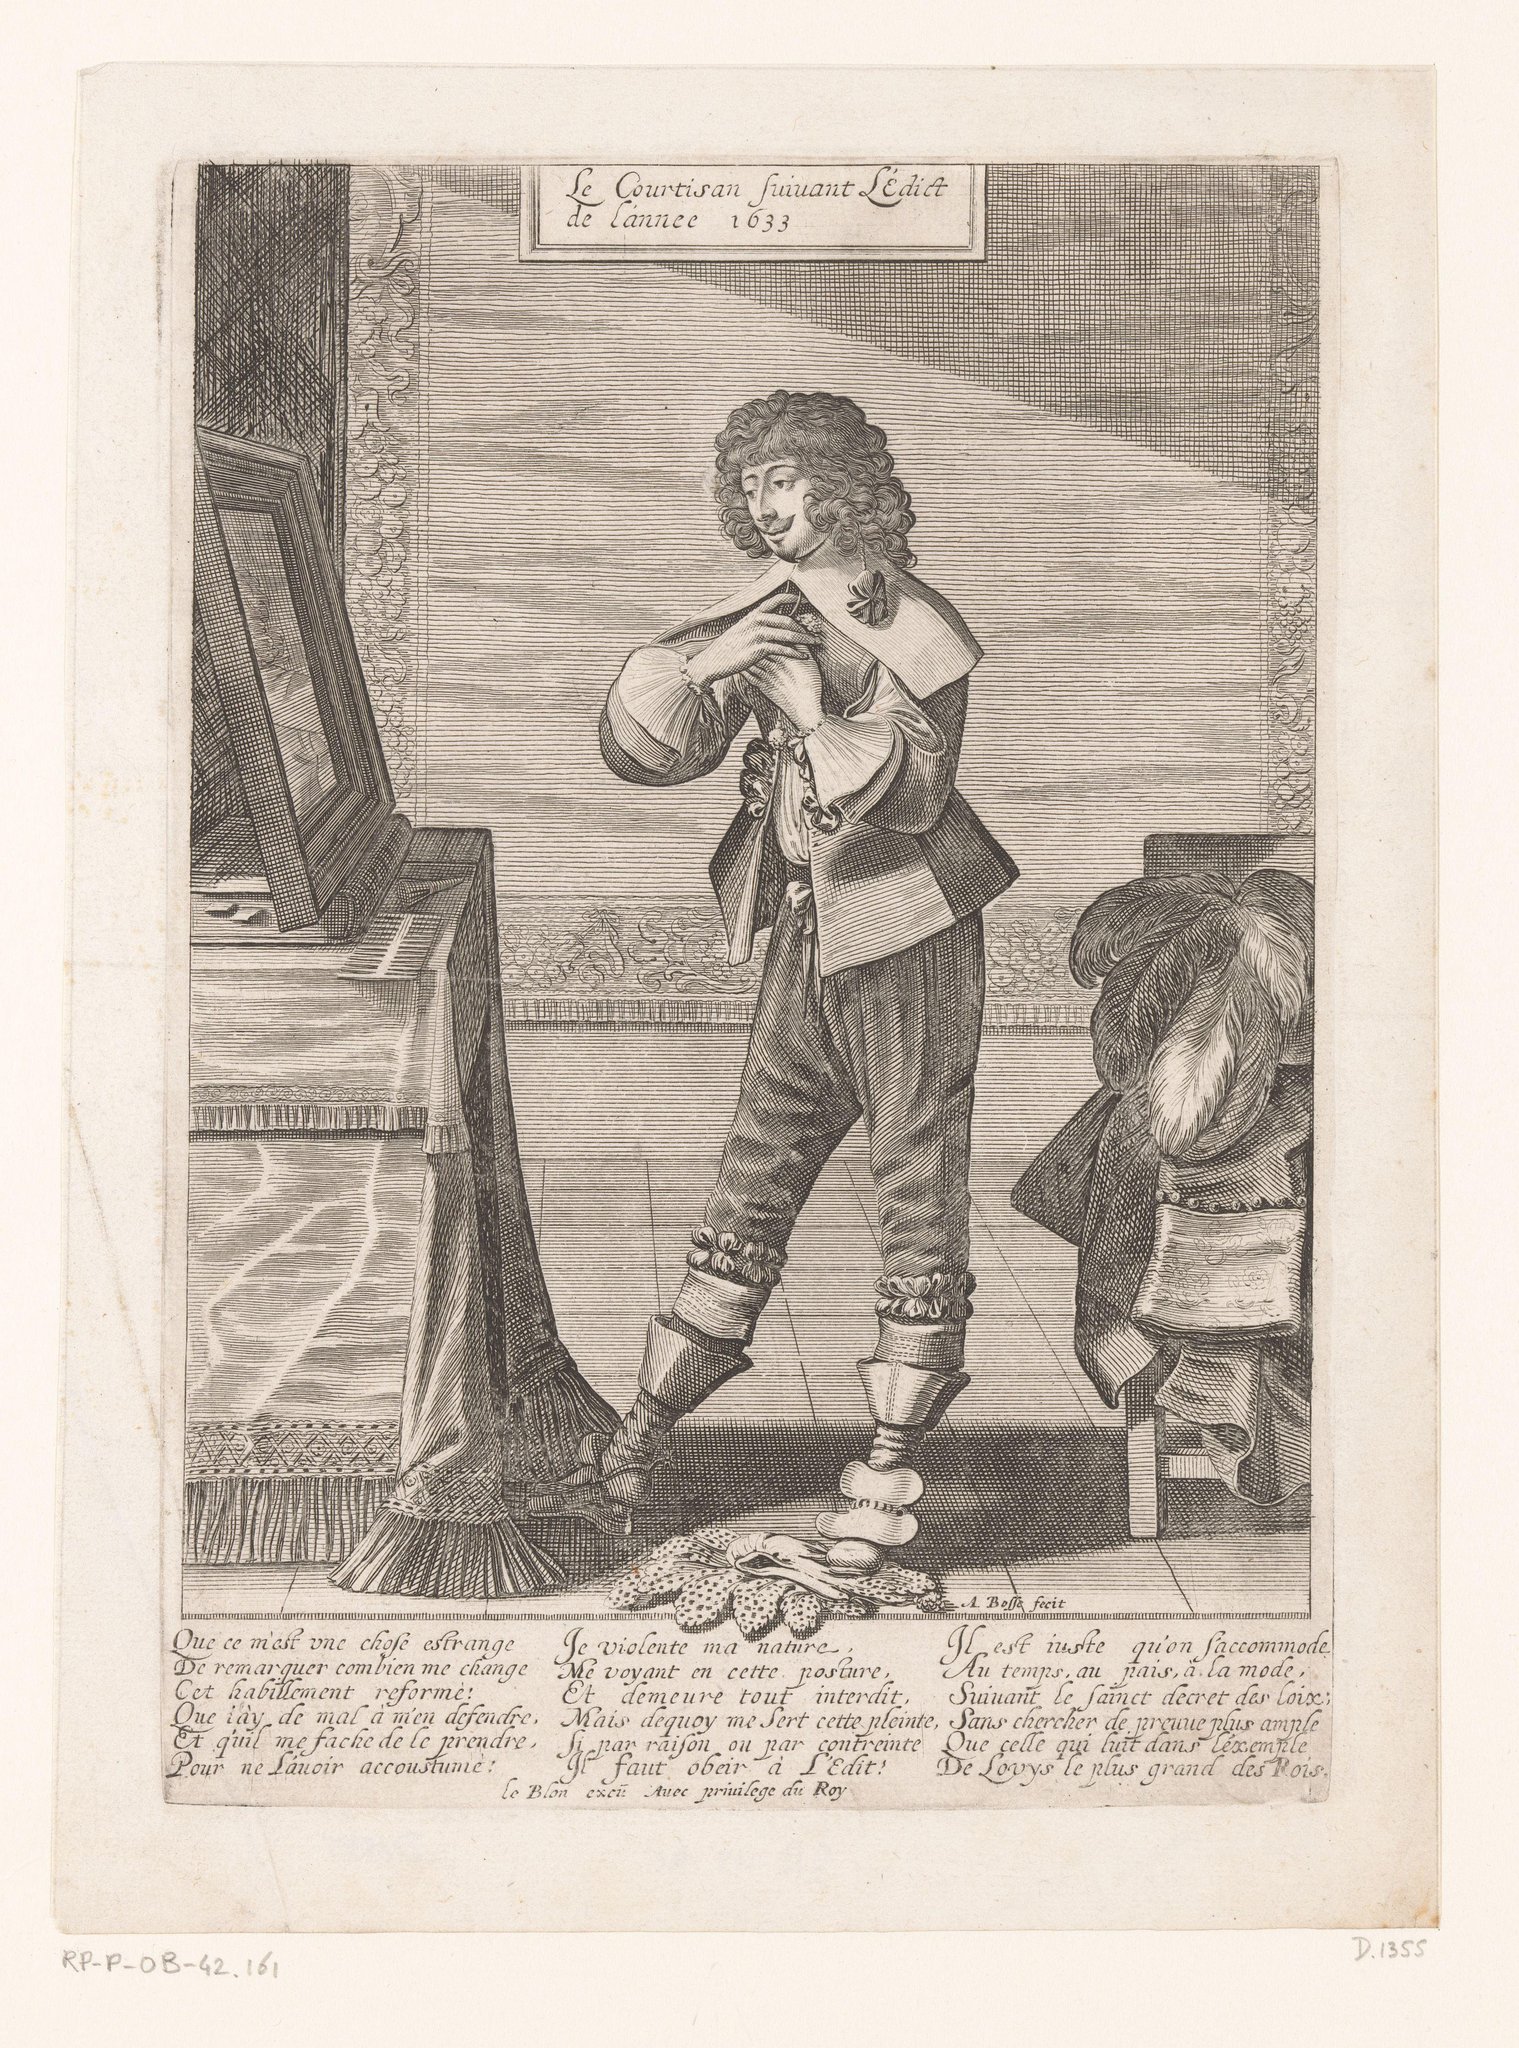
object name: costume print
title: Navolging van het edict van 1633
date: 1633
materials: paper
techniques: engraving, etching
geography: paris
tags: making toilet, dandy, beau, head-gear: hat (+ men's clothes), clothes, costume (+ men's clothes), neck-gear: collar (+ men's clothes), trousers, breeches, etc. (breeches) (+ men's clothes)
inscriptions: collector's mark: Lugt 240, caption: ‘Que ce m'est une chose estrange / De remarquer combien me change / Cet habillement reformé / Que i'ay de mal à m'en defendre / Et qu'il me fache de le prendre / Pour ne l'avoir accoustumé / Je violente ma nature / Me voyant en cette posture / Et demeure tout interdit / Mais de quoy me sert cette pleinte / Si par raison ou par contreinte / Il faut obeir à l'édit ! / Il est juste qu'on s'accommode / Au temps, au païs, à la mode / Sans chercher de preuve plus ample / Que celle qui lui dans l'exemple / De Louys le plus grand des Roys.’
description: In 1633 werd een edict van Lodewijk XIII afgekondigd waarin het dragen van kant aan kragen, manchetten en canons werd verboden. Dit was bedoeld als bescherming tegen de import van deze en andere kostbare stoffen. De hoveling hier, die toilet maakt voor de spiegel, is gekleed volgens de sobere regels van dit Edict. Hij staat met zijn voeten op een kanten kraag. Nu draagt hij een eenvoudig glad model. De hoge taille is versierd met strikken die geen functie meer hebben, want de broek is nu aan een broekband bevestigd, die van voren met een strik is gesloten. De lange haarlok, die eindigt in een strik, hangt op zijn linkerschouder. Deze heet 'cadenette' naar de uitvinder, de heer cadenet. Achter hem, op een stoel, liggen mantel en hoed. Onderschrift in het Frans waaruit duidelijk wordt dat de man zich niet prettig voelt in de 'reformkleding', maar gehoorzaam wil zijn aan de koning van Frankrijk.